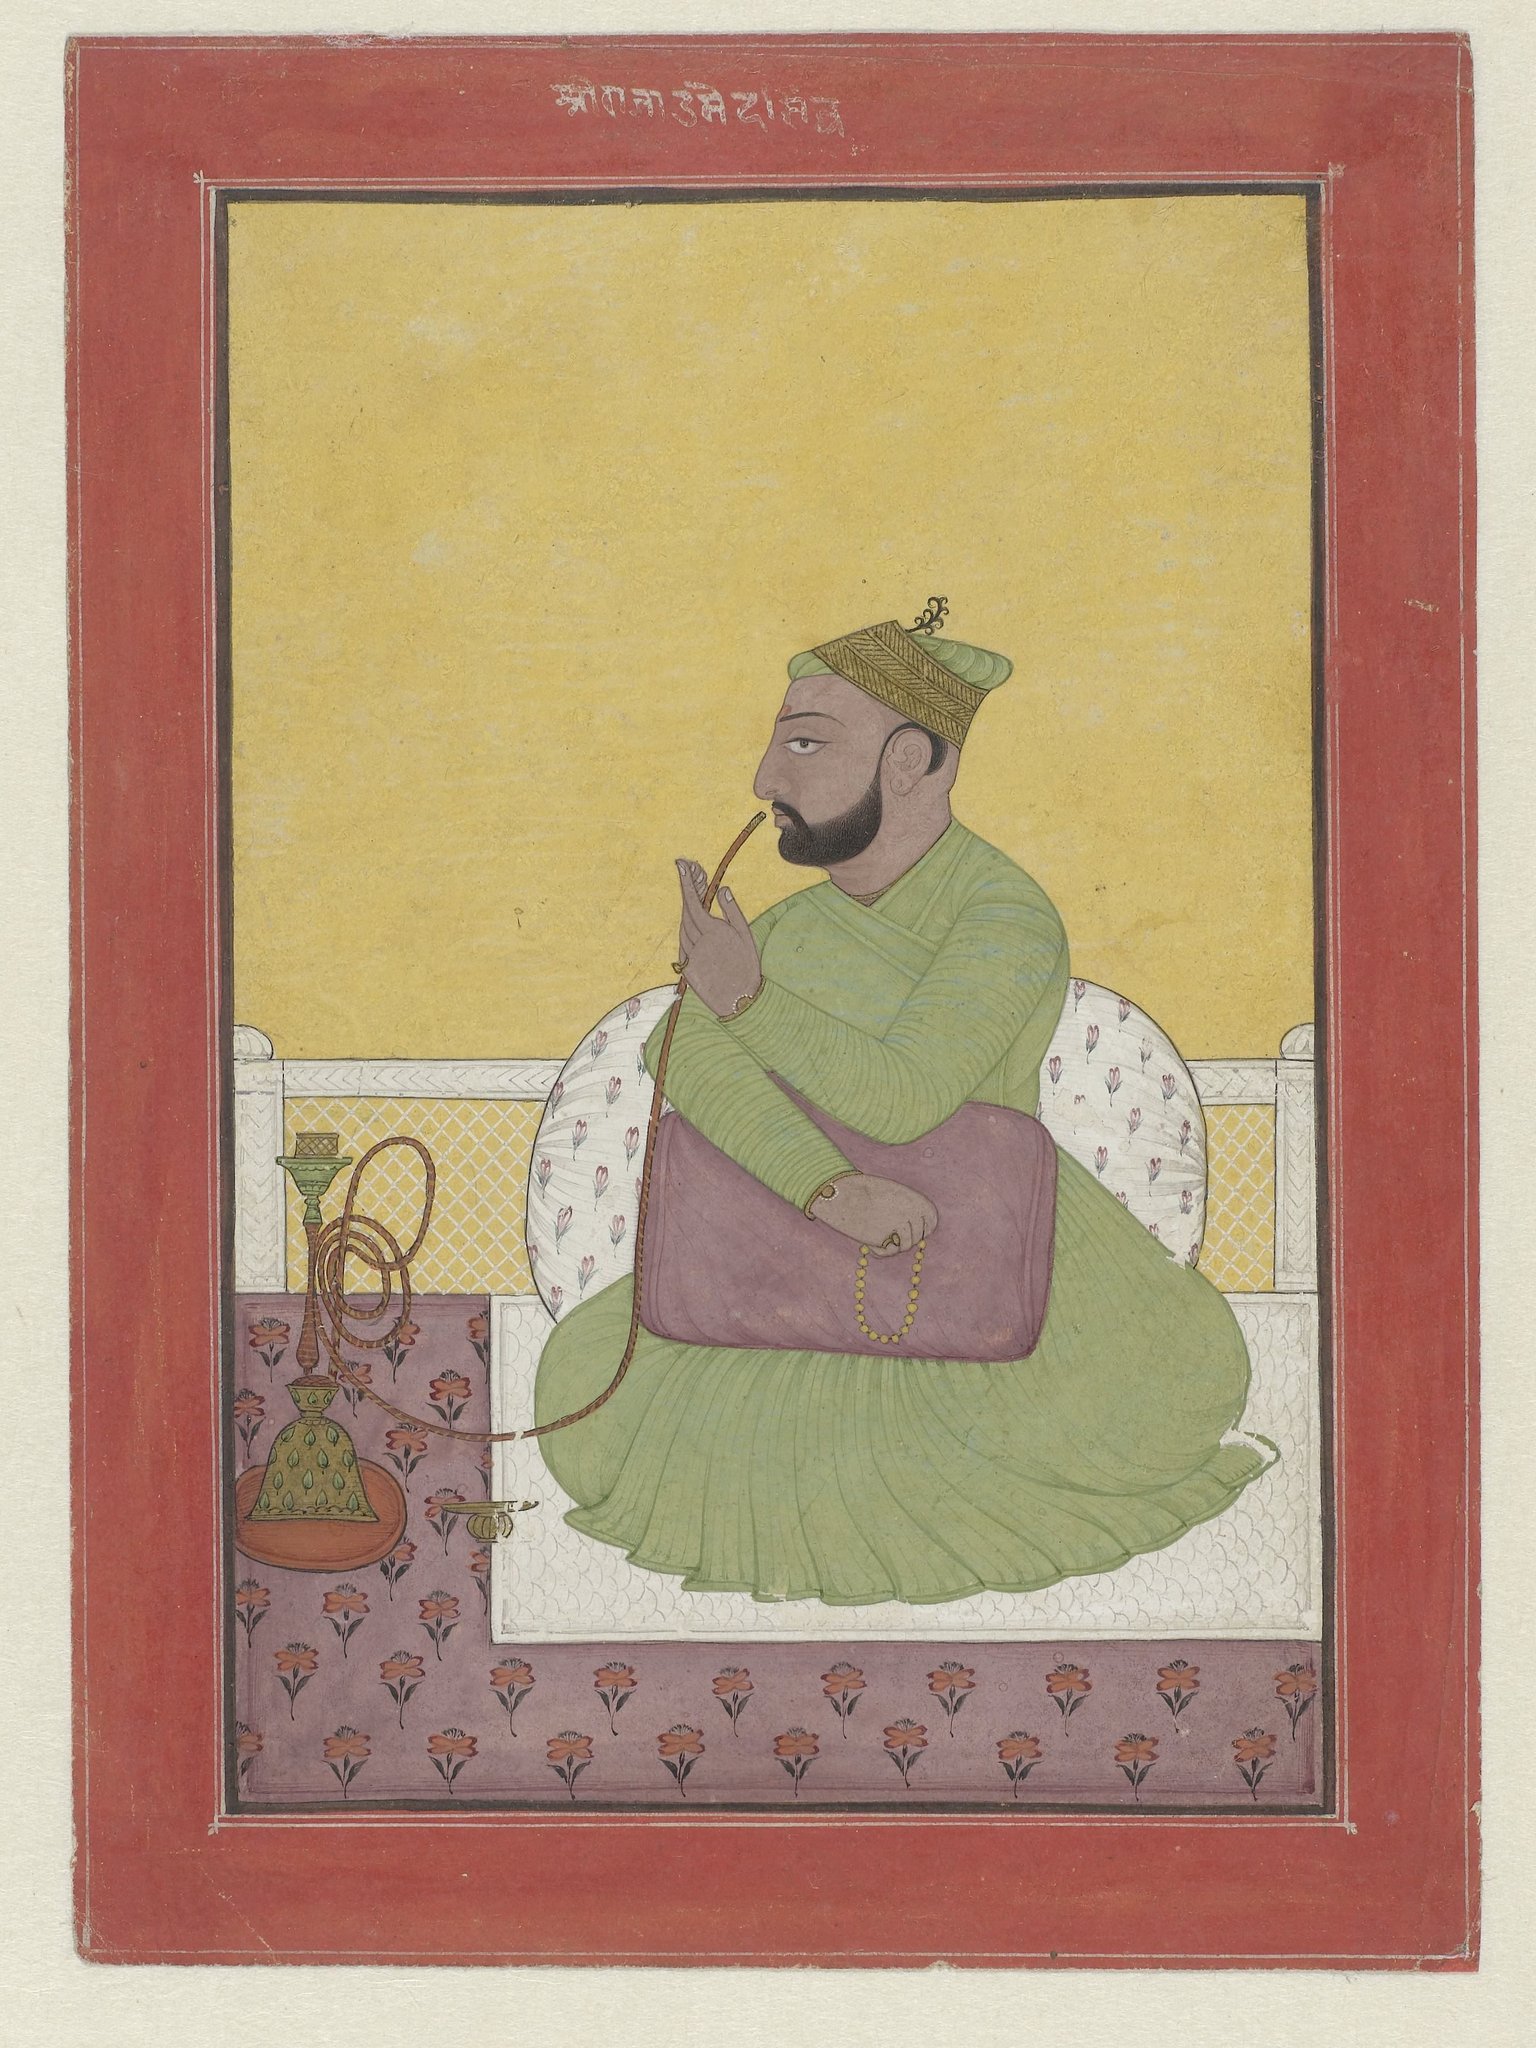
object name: indian miniature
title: Portret van Umed Singh van Chamba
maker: Anonymous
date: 1750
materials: paper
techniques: brush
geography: chamba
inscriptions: inscription: ‘Shri Raja Umed Singh’, inscription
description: Portret van Umed Singh van Chamba (1748-1764), in een groen gewaad tegen een rolkussen geleund met profiel naar links; een waterpijp rokend. De voorstelling is omlijst door een smalle zwarte rand en een brede rode rand met witte kaderlijntjes.